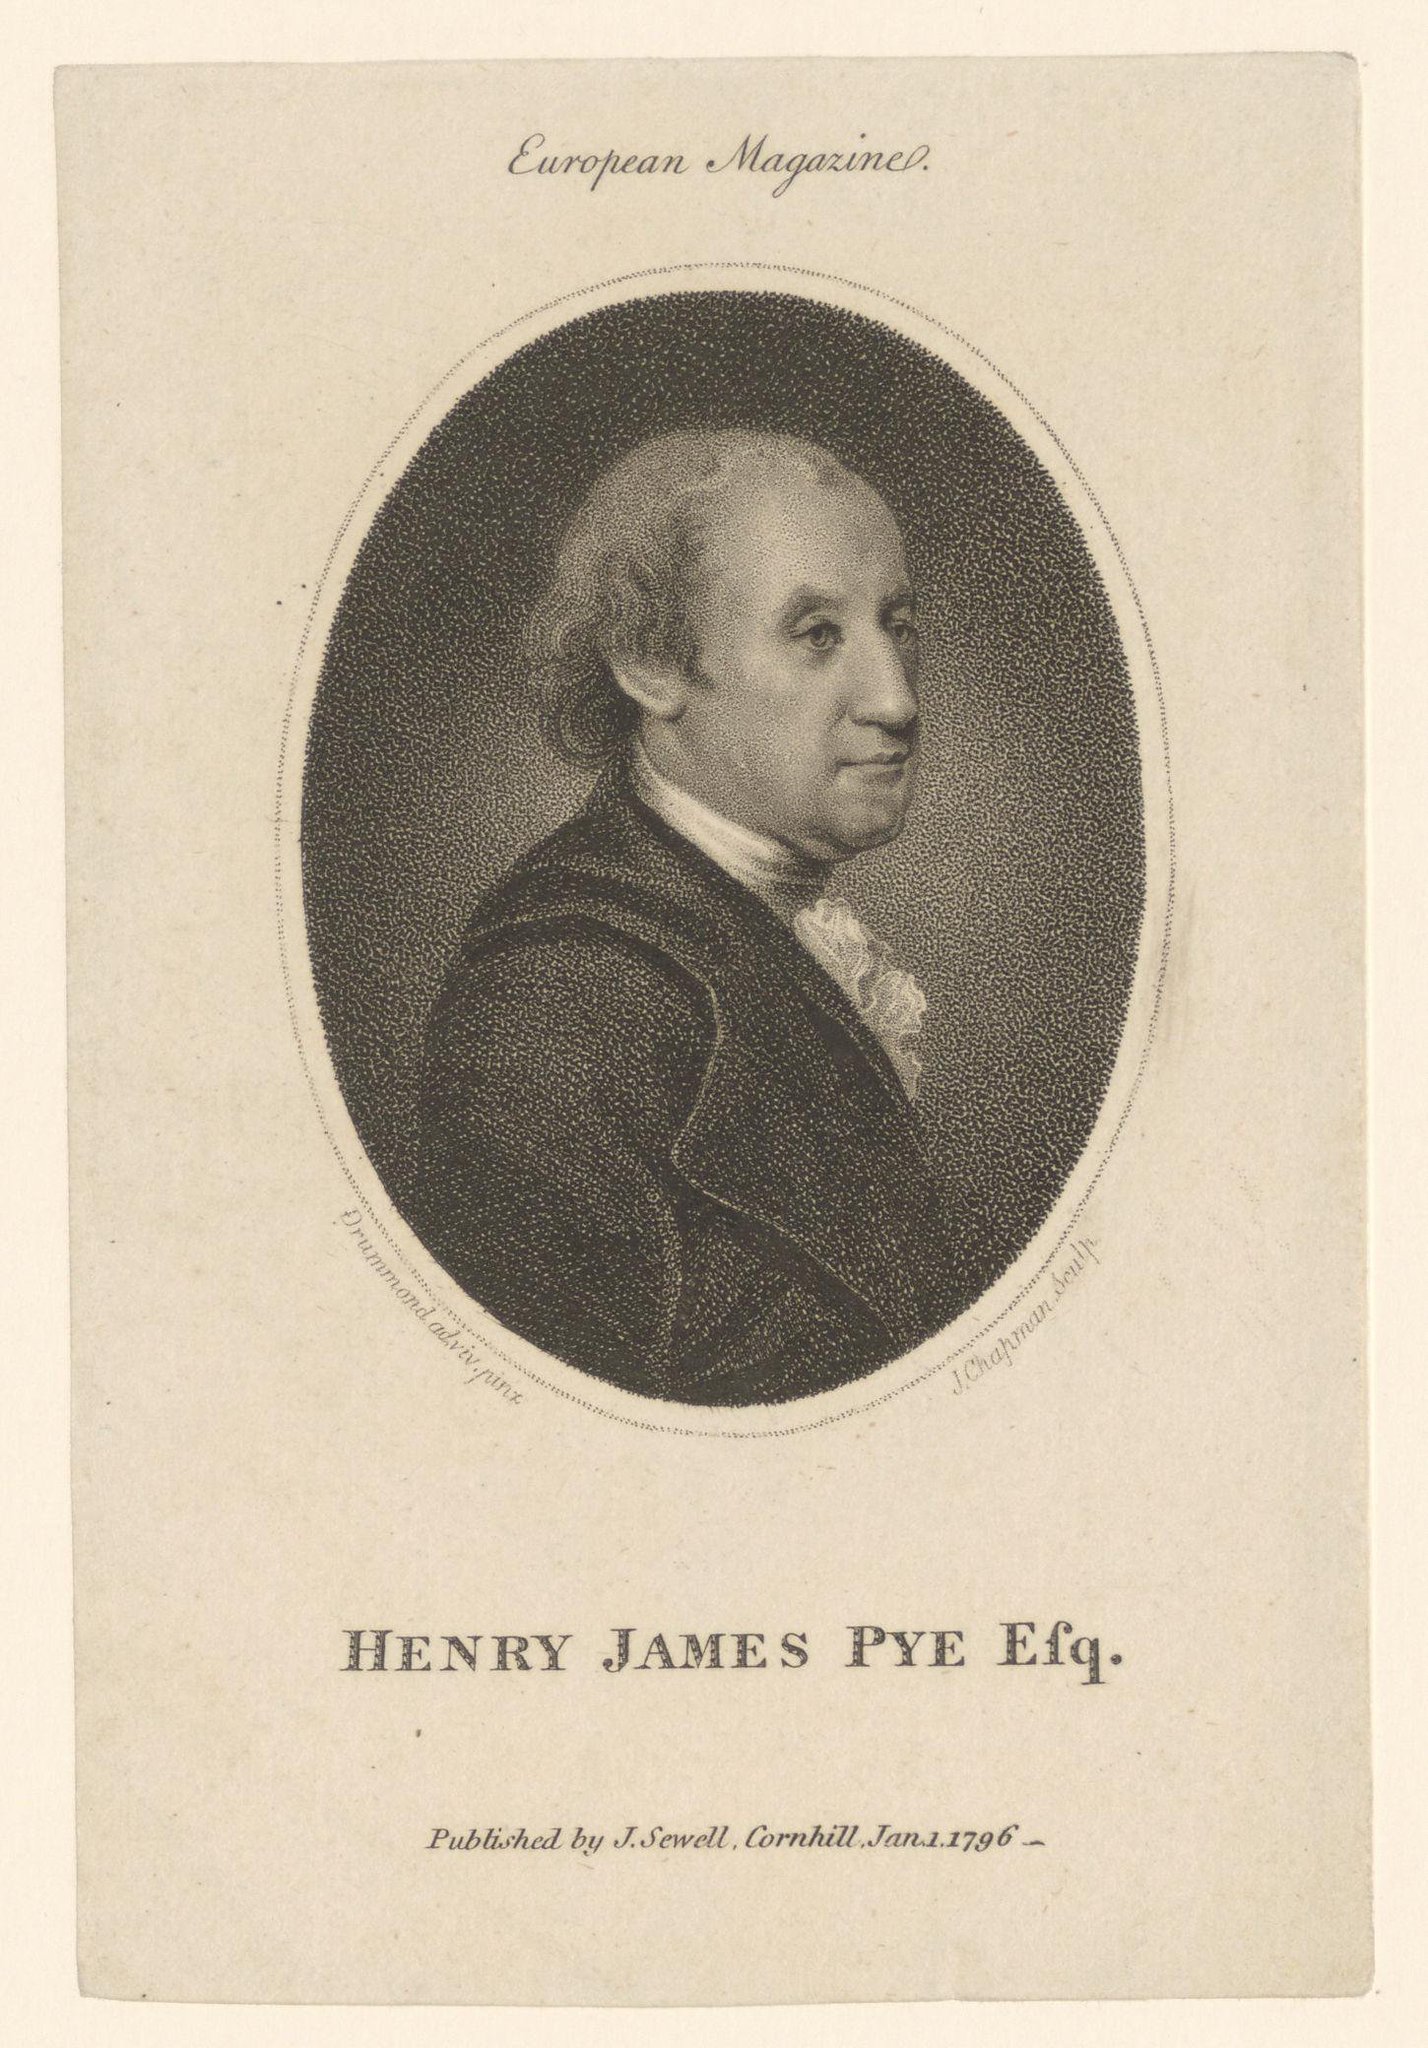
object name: print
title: Portret van Henry James Pye Esq.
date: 1797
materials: paper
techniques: stippling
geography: london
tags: london, historical persons, writer, poet, author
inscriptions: collector's mark: Lugt 2228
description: Prent gebruikt in: European Magazine, nr. 29, januari 1796, pl. 1.